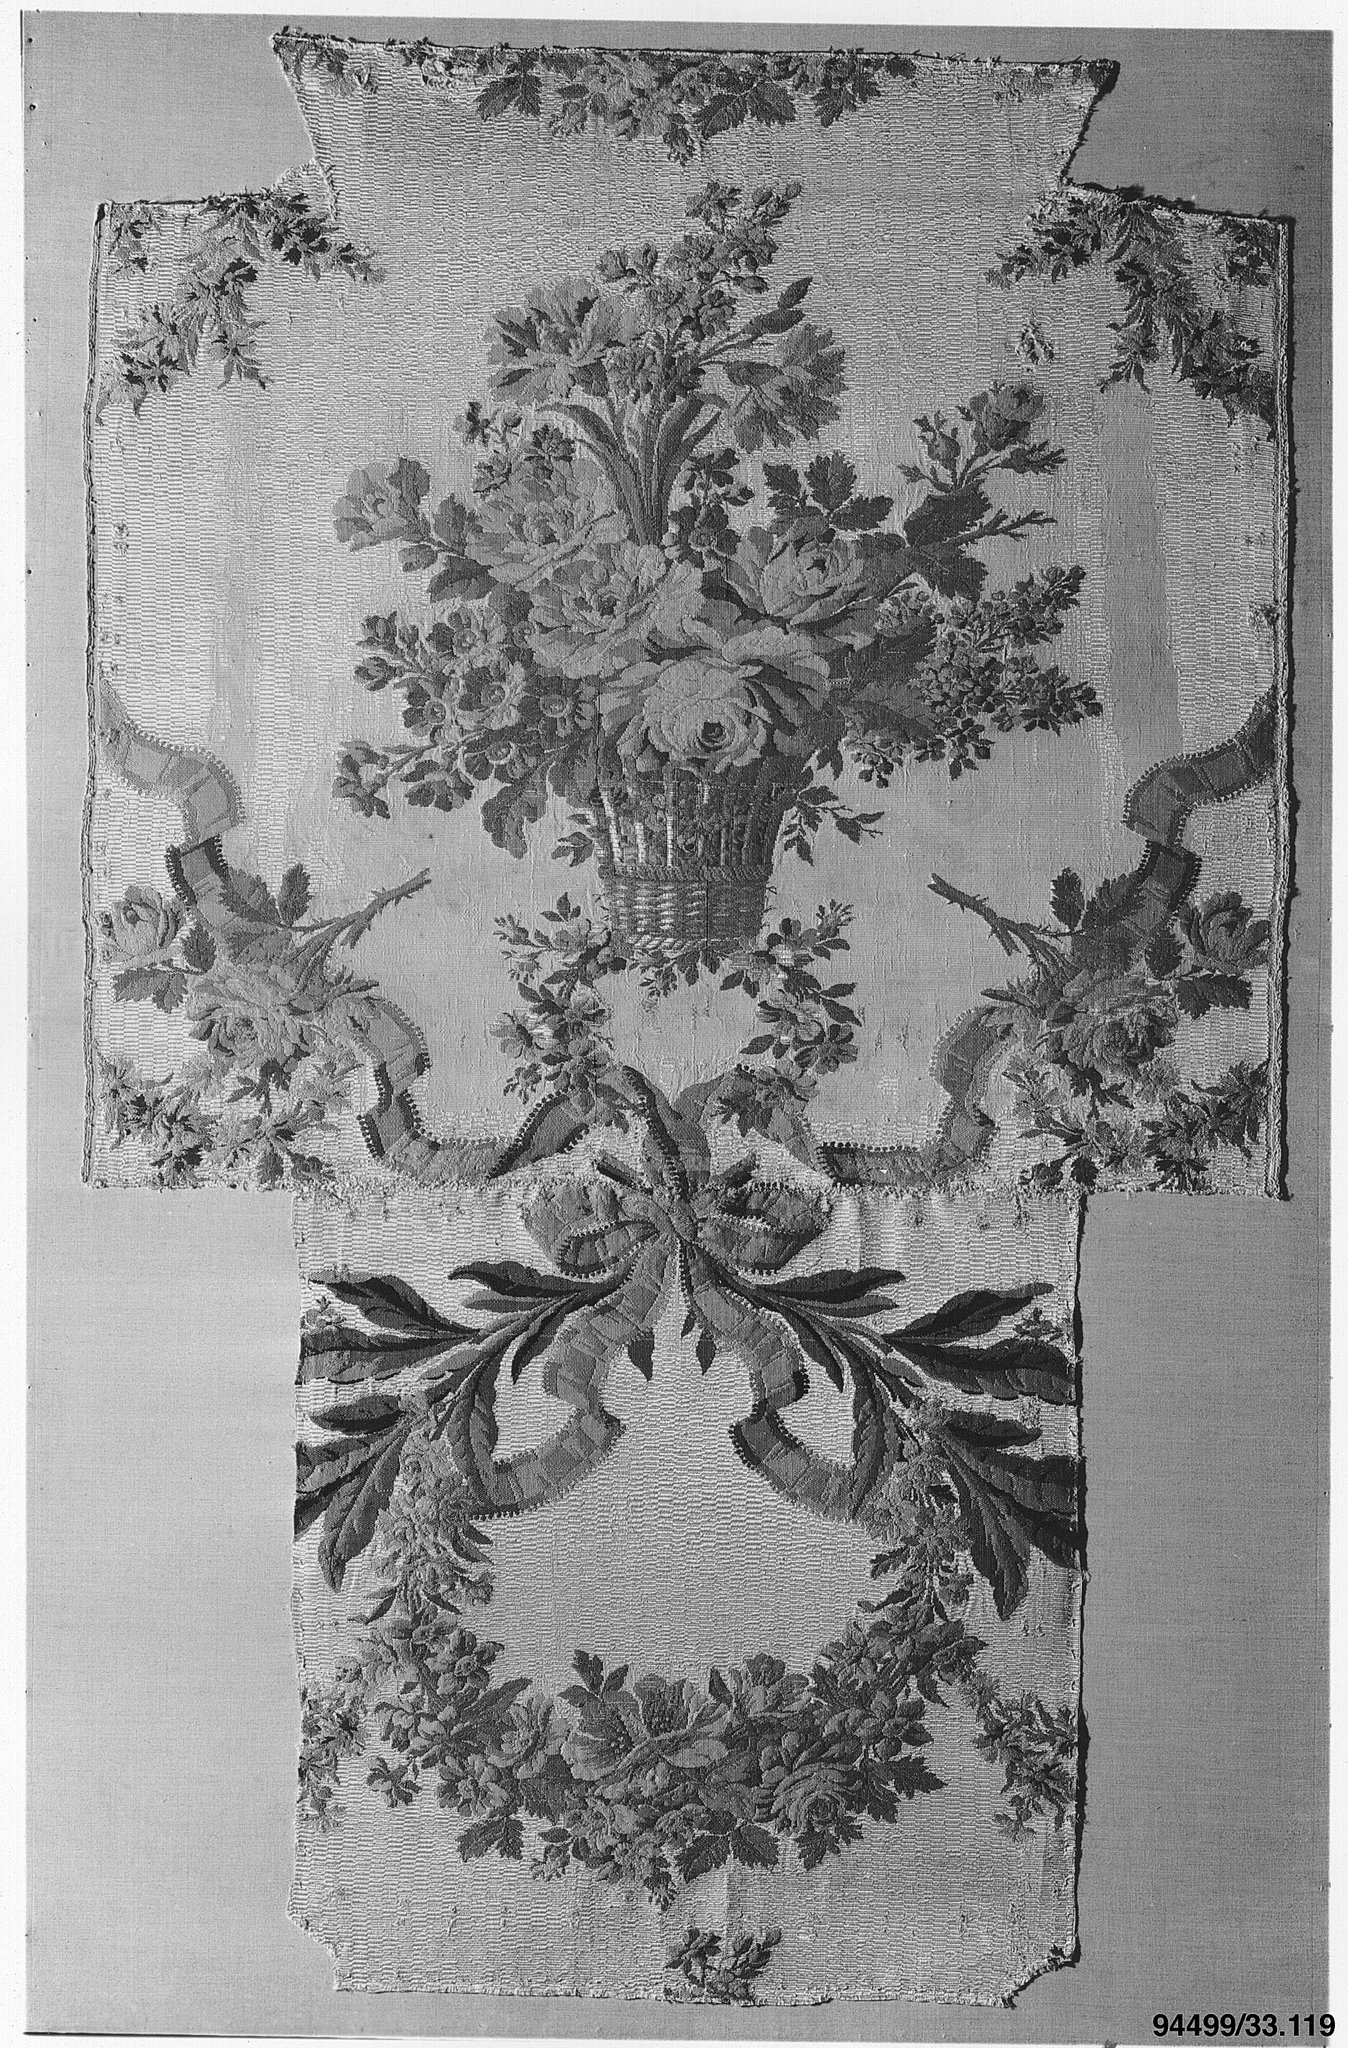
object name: upholstery fragment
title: Woven silk upholstery for a chair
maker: philippe de lasalle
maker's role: designer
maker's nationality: french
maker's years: 1723-1804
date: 1770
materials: silk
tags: flowers